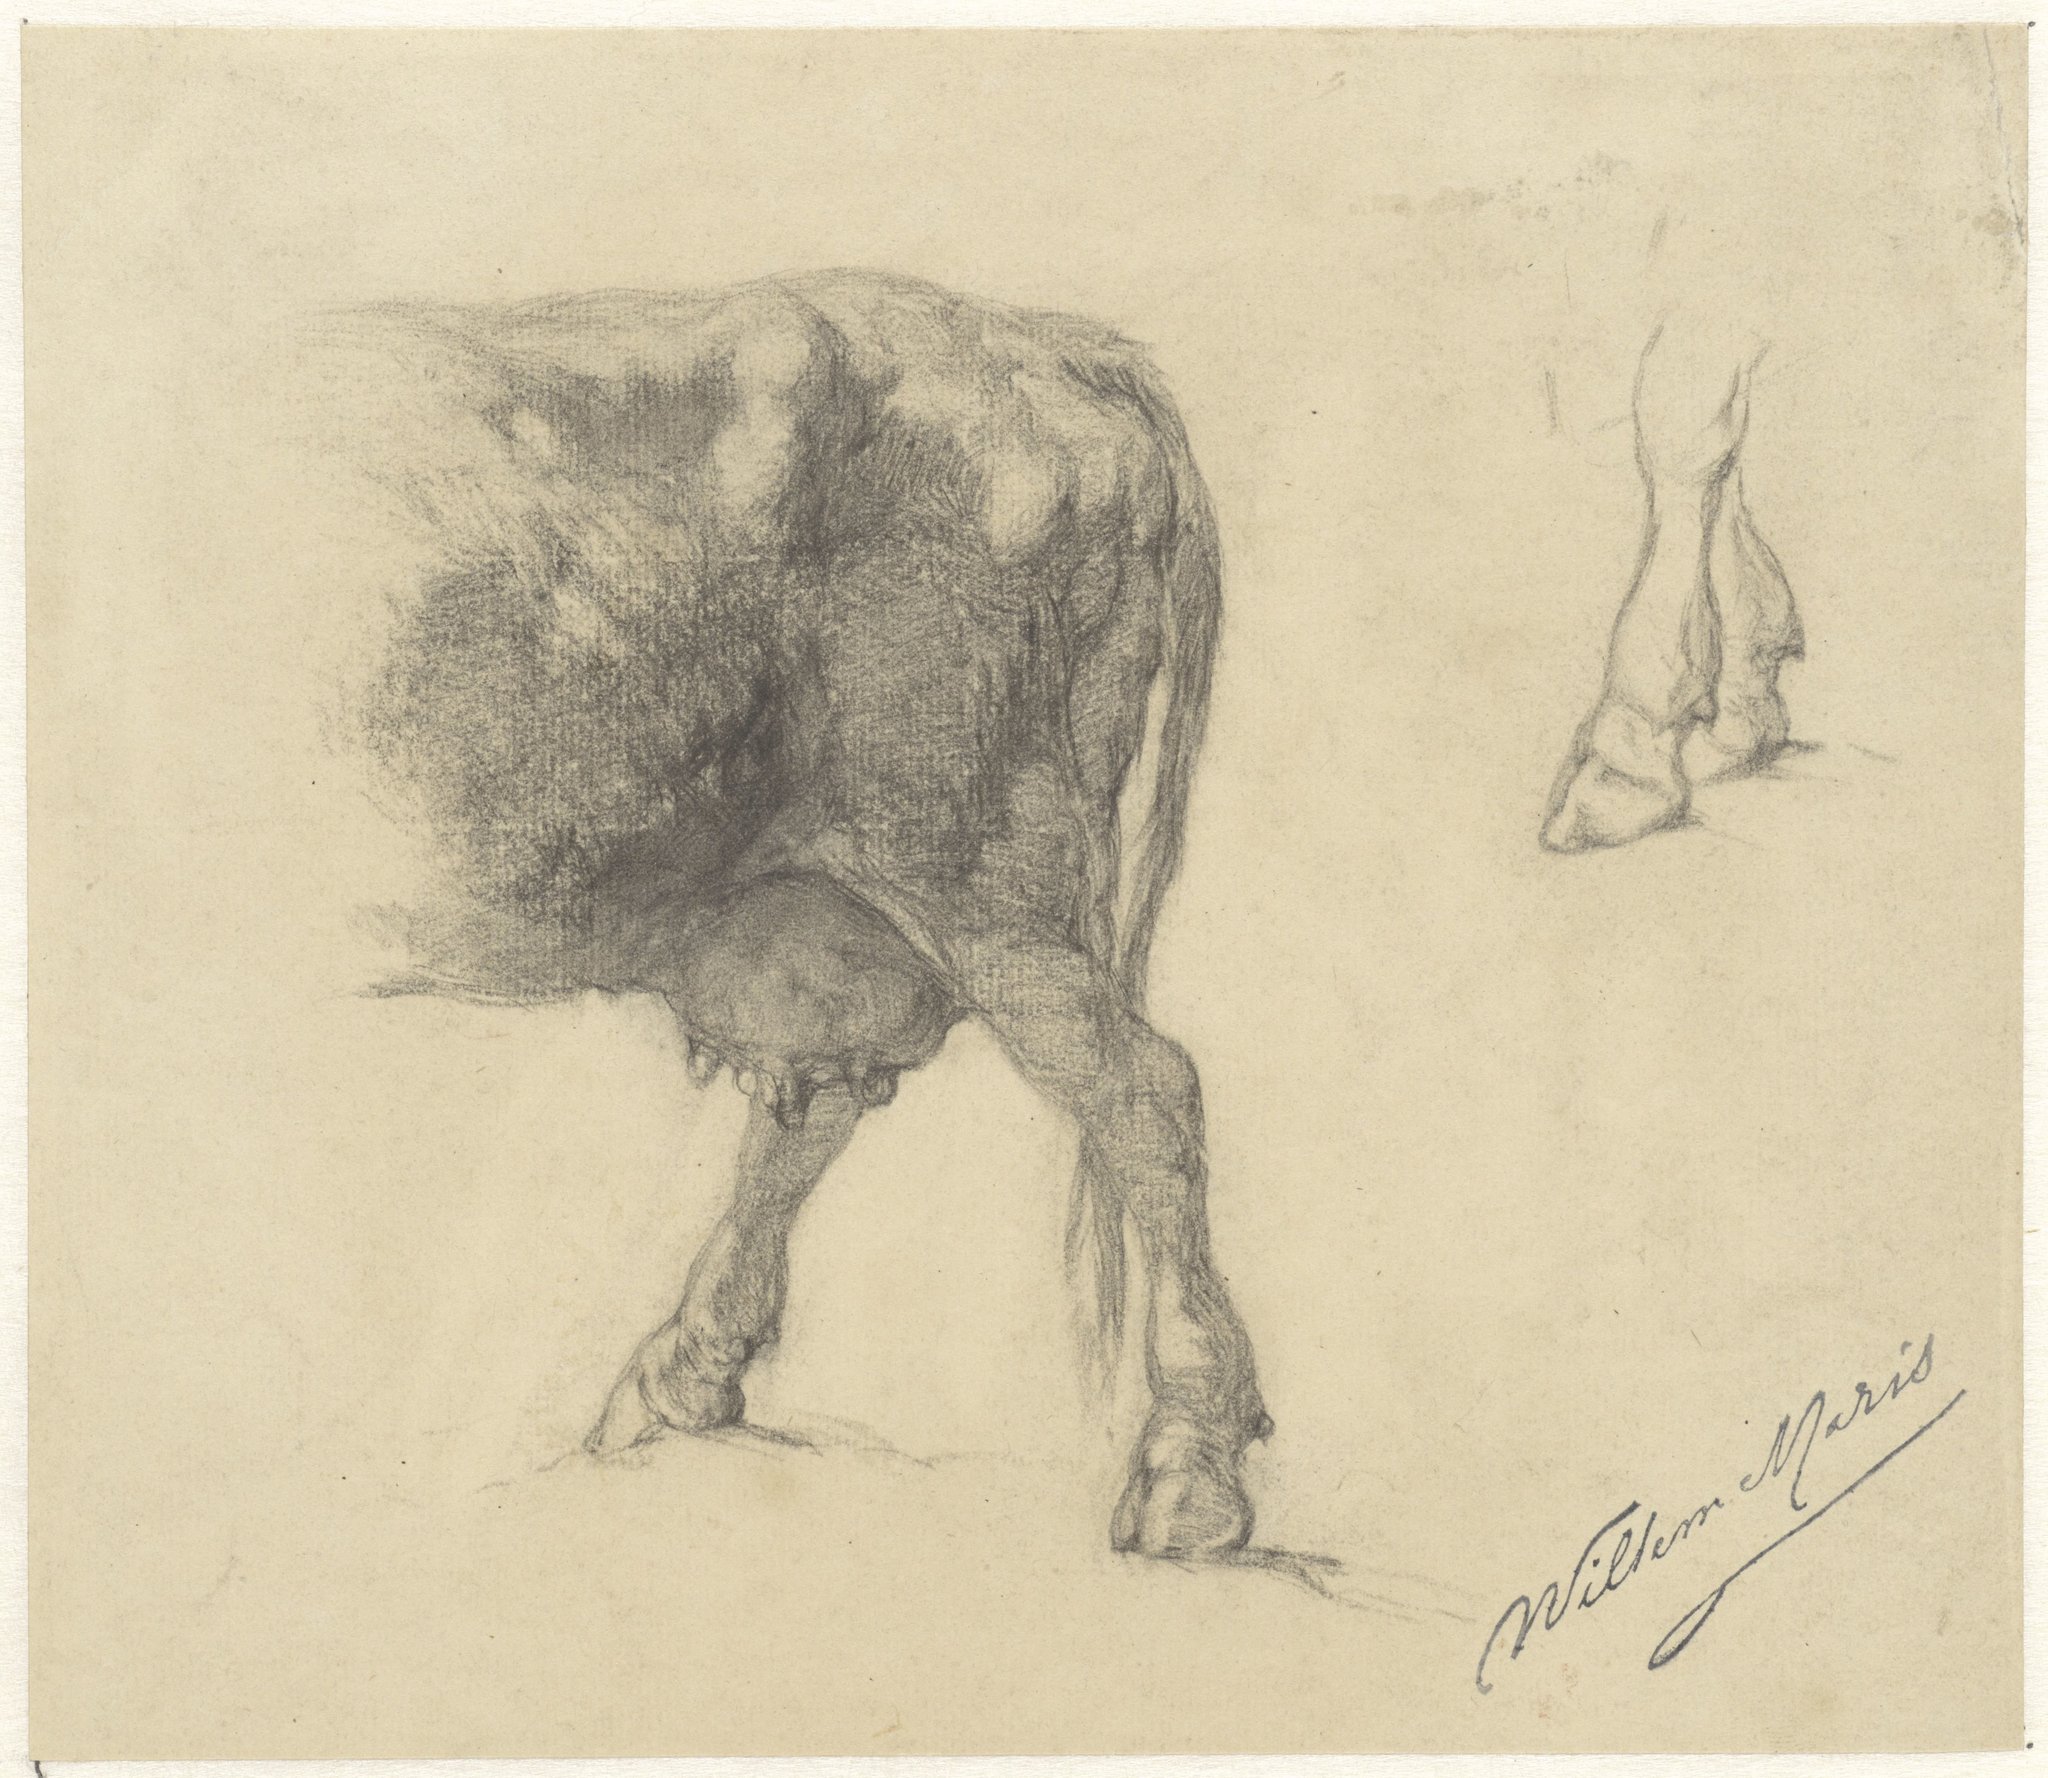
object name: drawing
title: Achterlijf van een koe en twee poten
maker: willem maris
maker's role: draughtsman, painter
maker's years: 1844-1910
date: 1854-1910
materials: chalk, paper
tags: cow